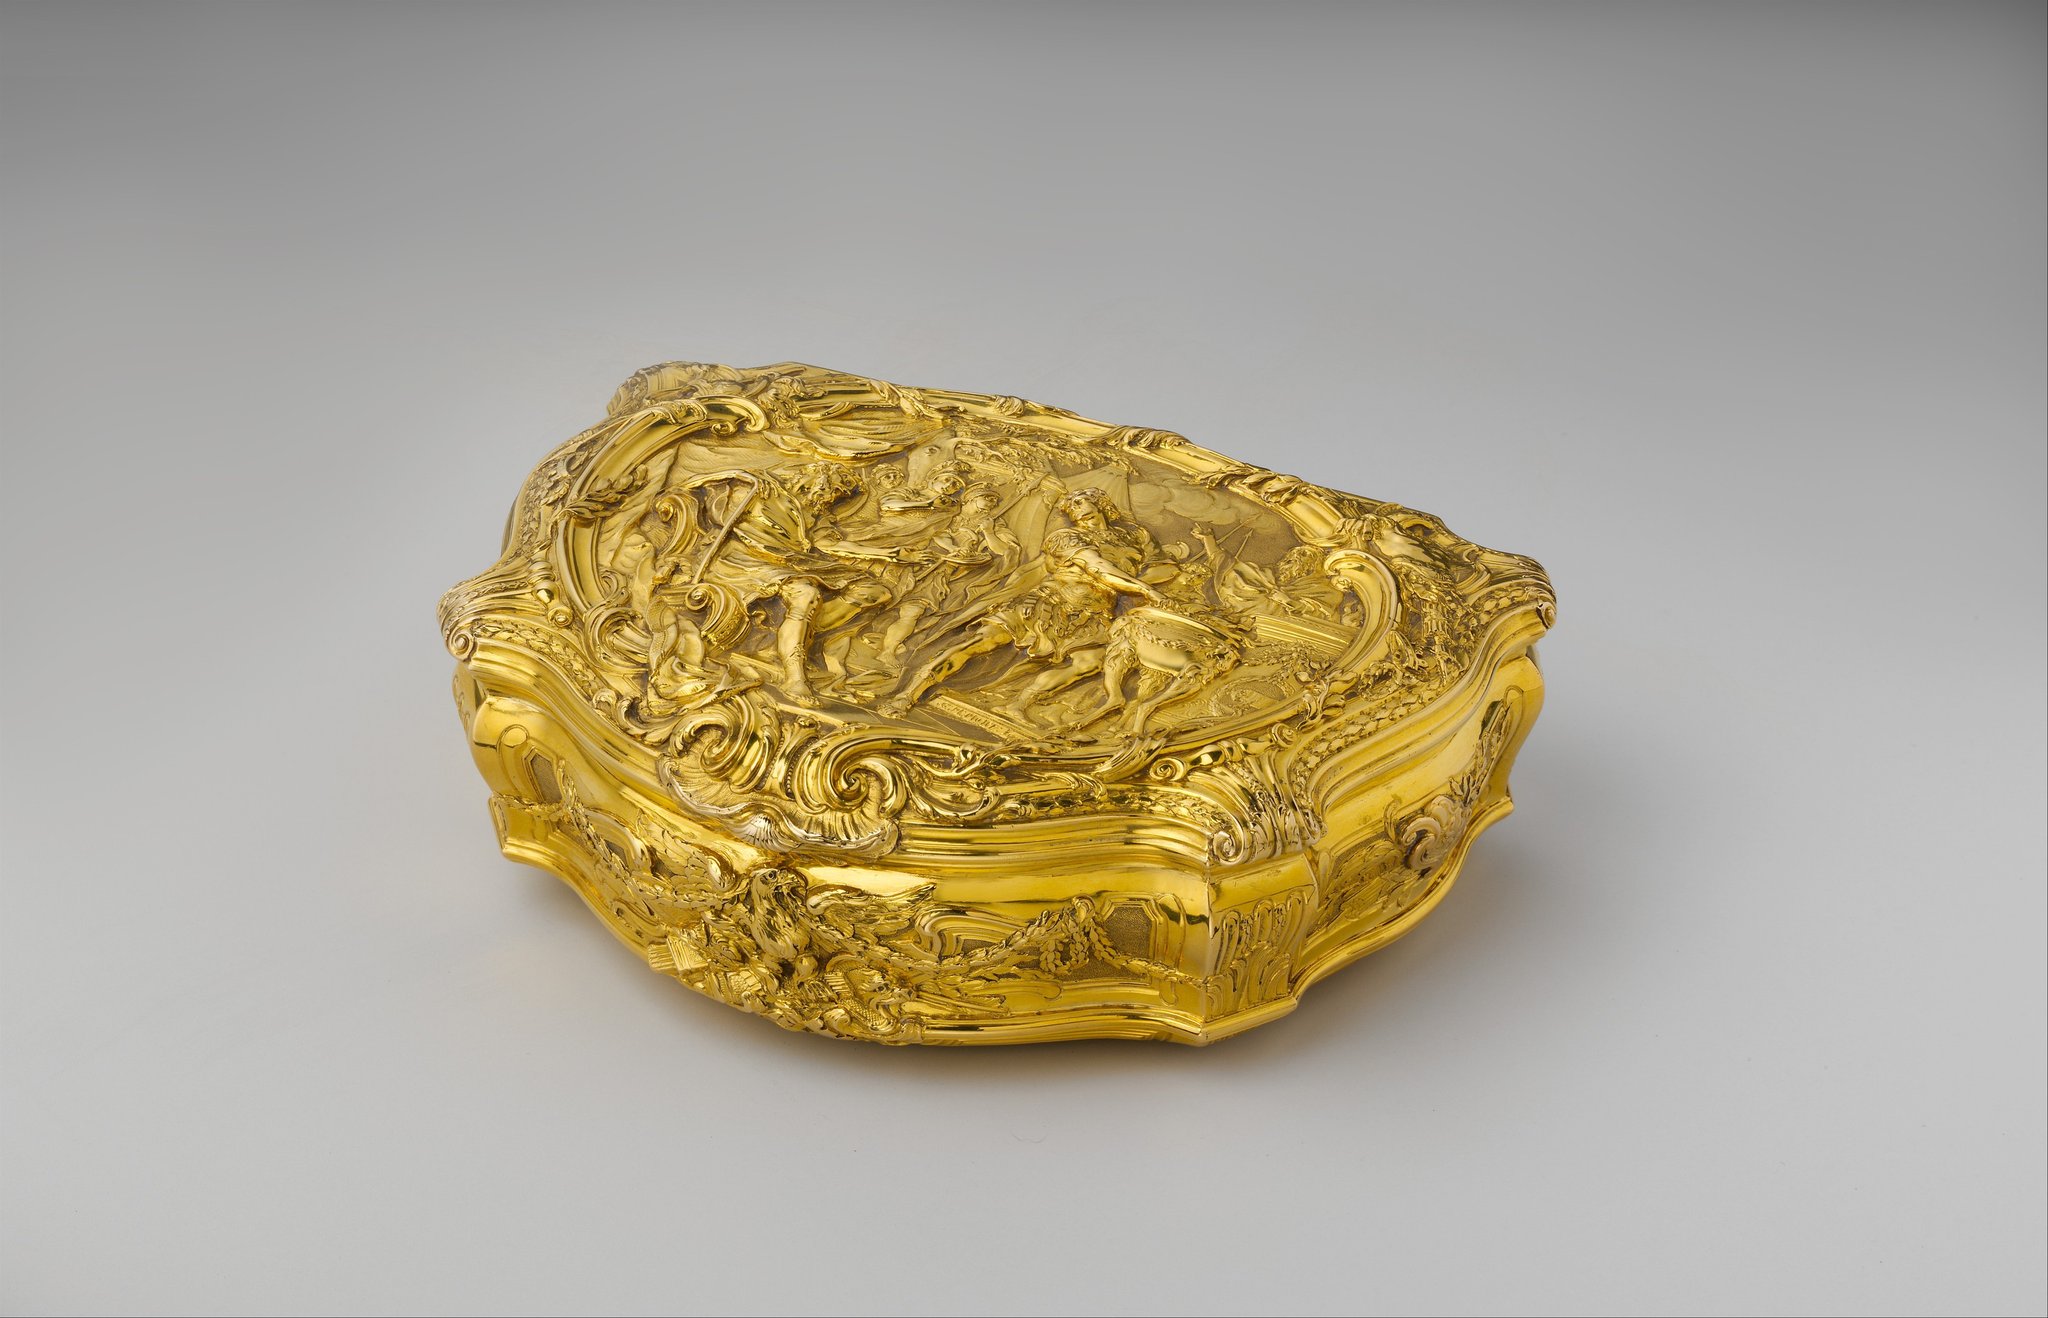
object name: box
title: Box with scene depicting Roman hero Gaius Mucius Scaevola before the Etruscan king Lars Porsena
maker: p r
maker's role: goldsmith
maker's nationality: british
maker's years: 1700-1750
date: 1741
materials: gold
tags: eagles,kings,men